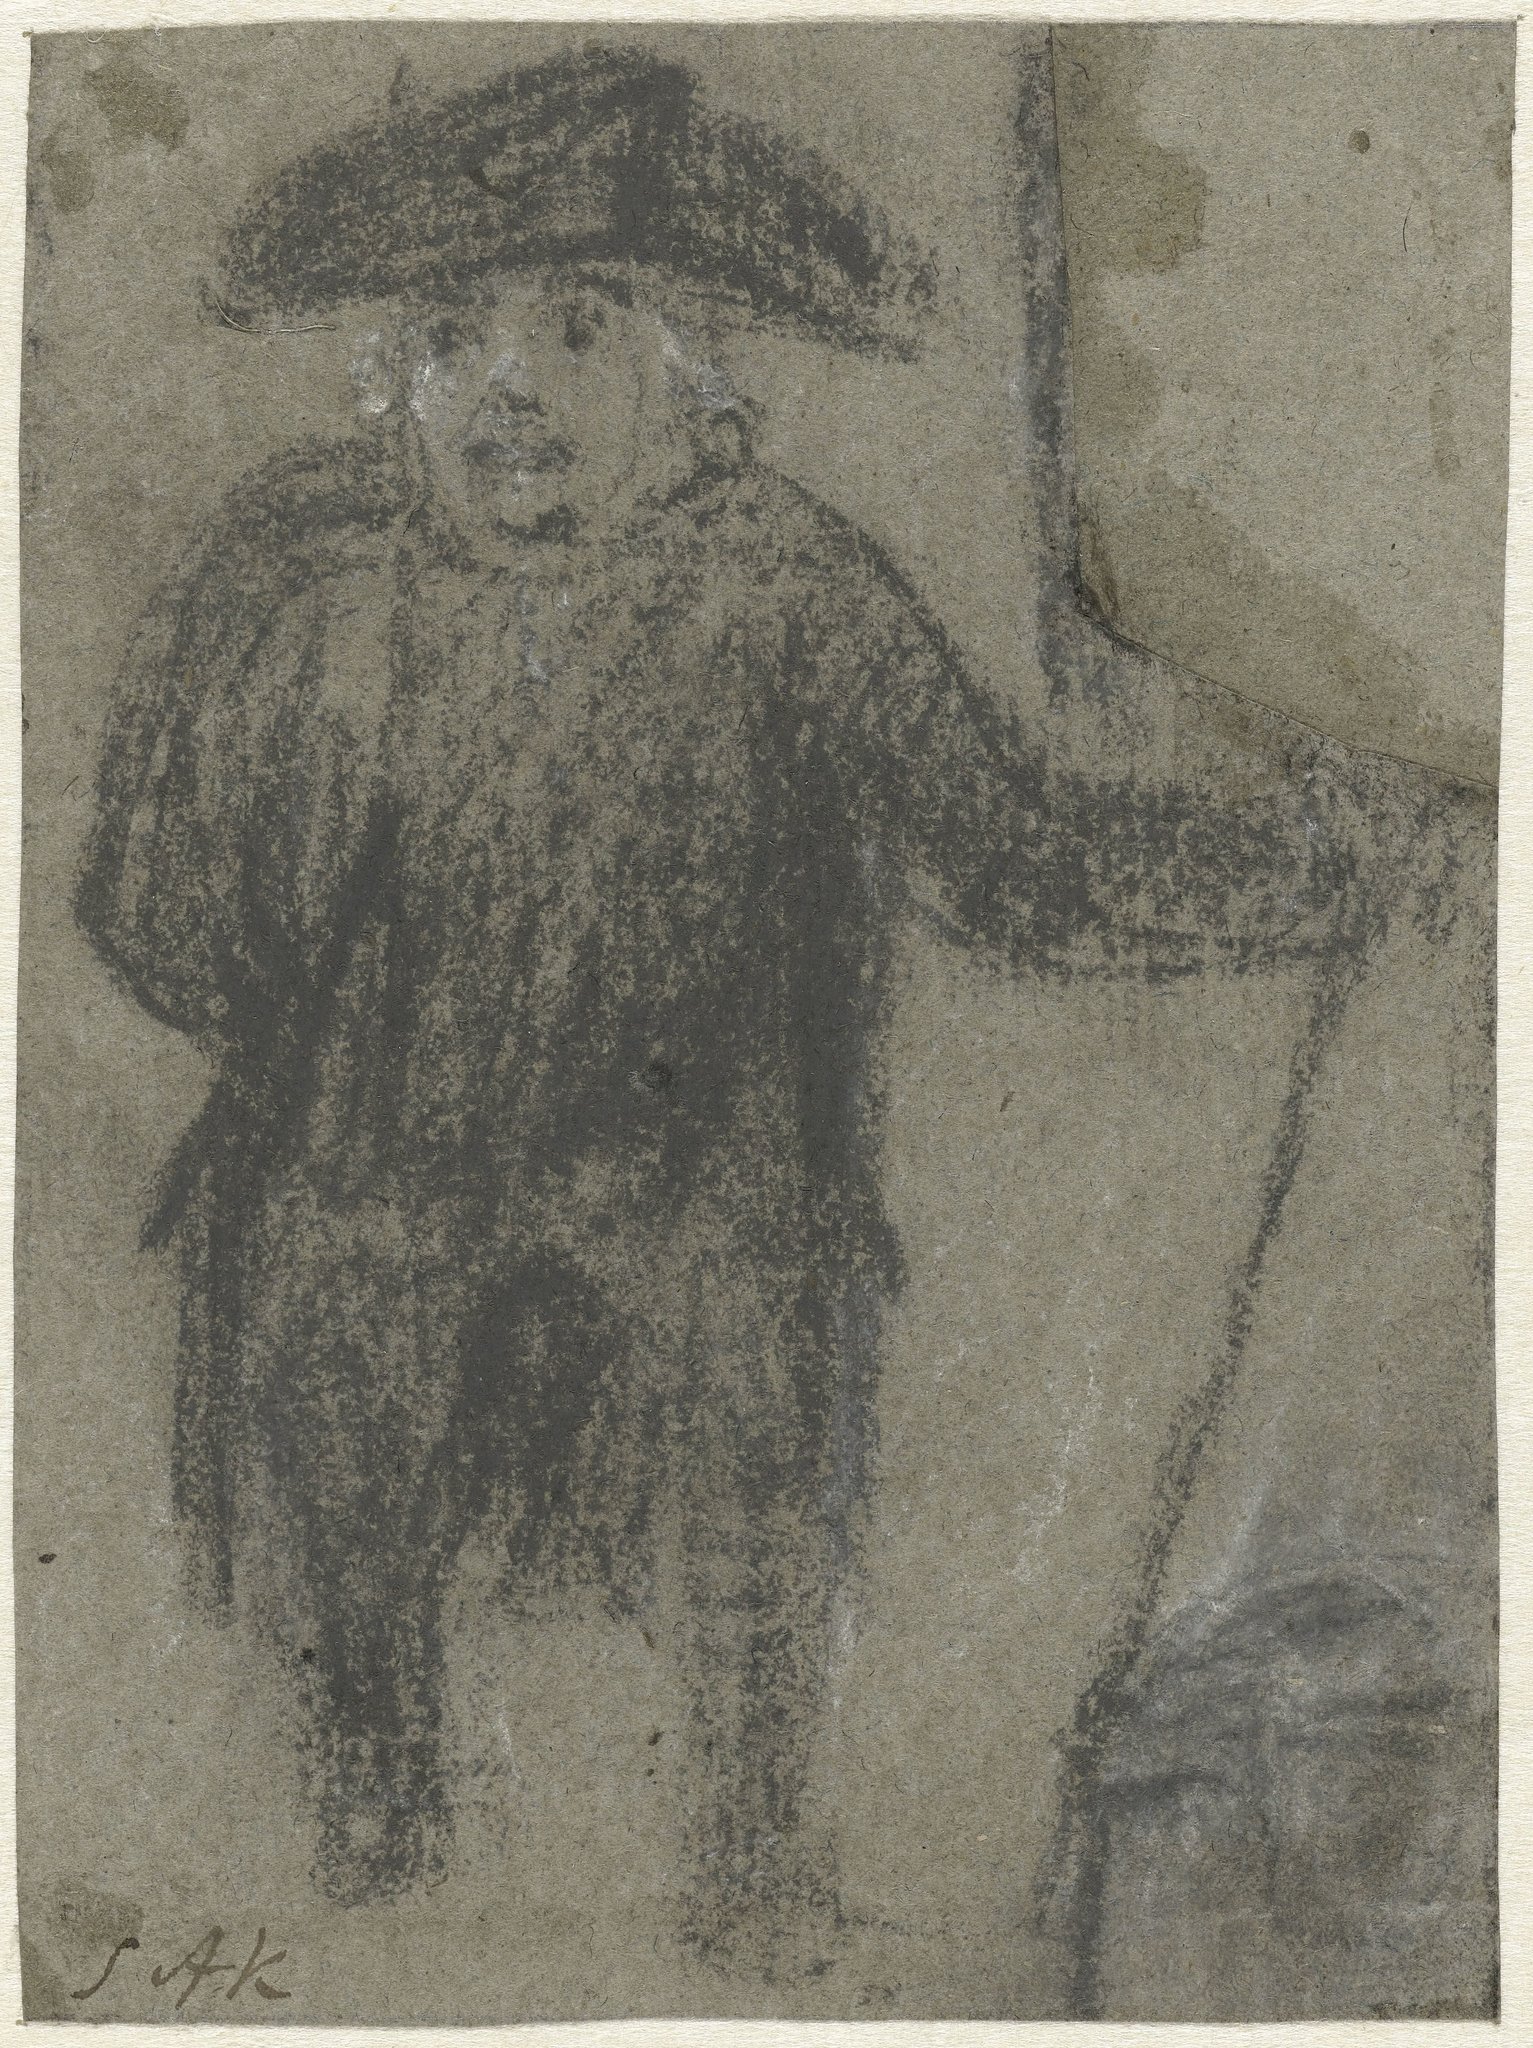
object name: drawing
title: Karikatuur van een staande dikke man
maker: simon andreas krausz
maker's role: draughtsman, print maker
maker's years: 1760-1825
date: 1770-1825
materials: chalk, paper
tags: caricatures (human types)